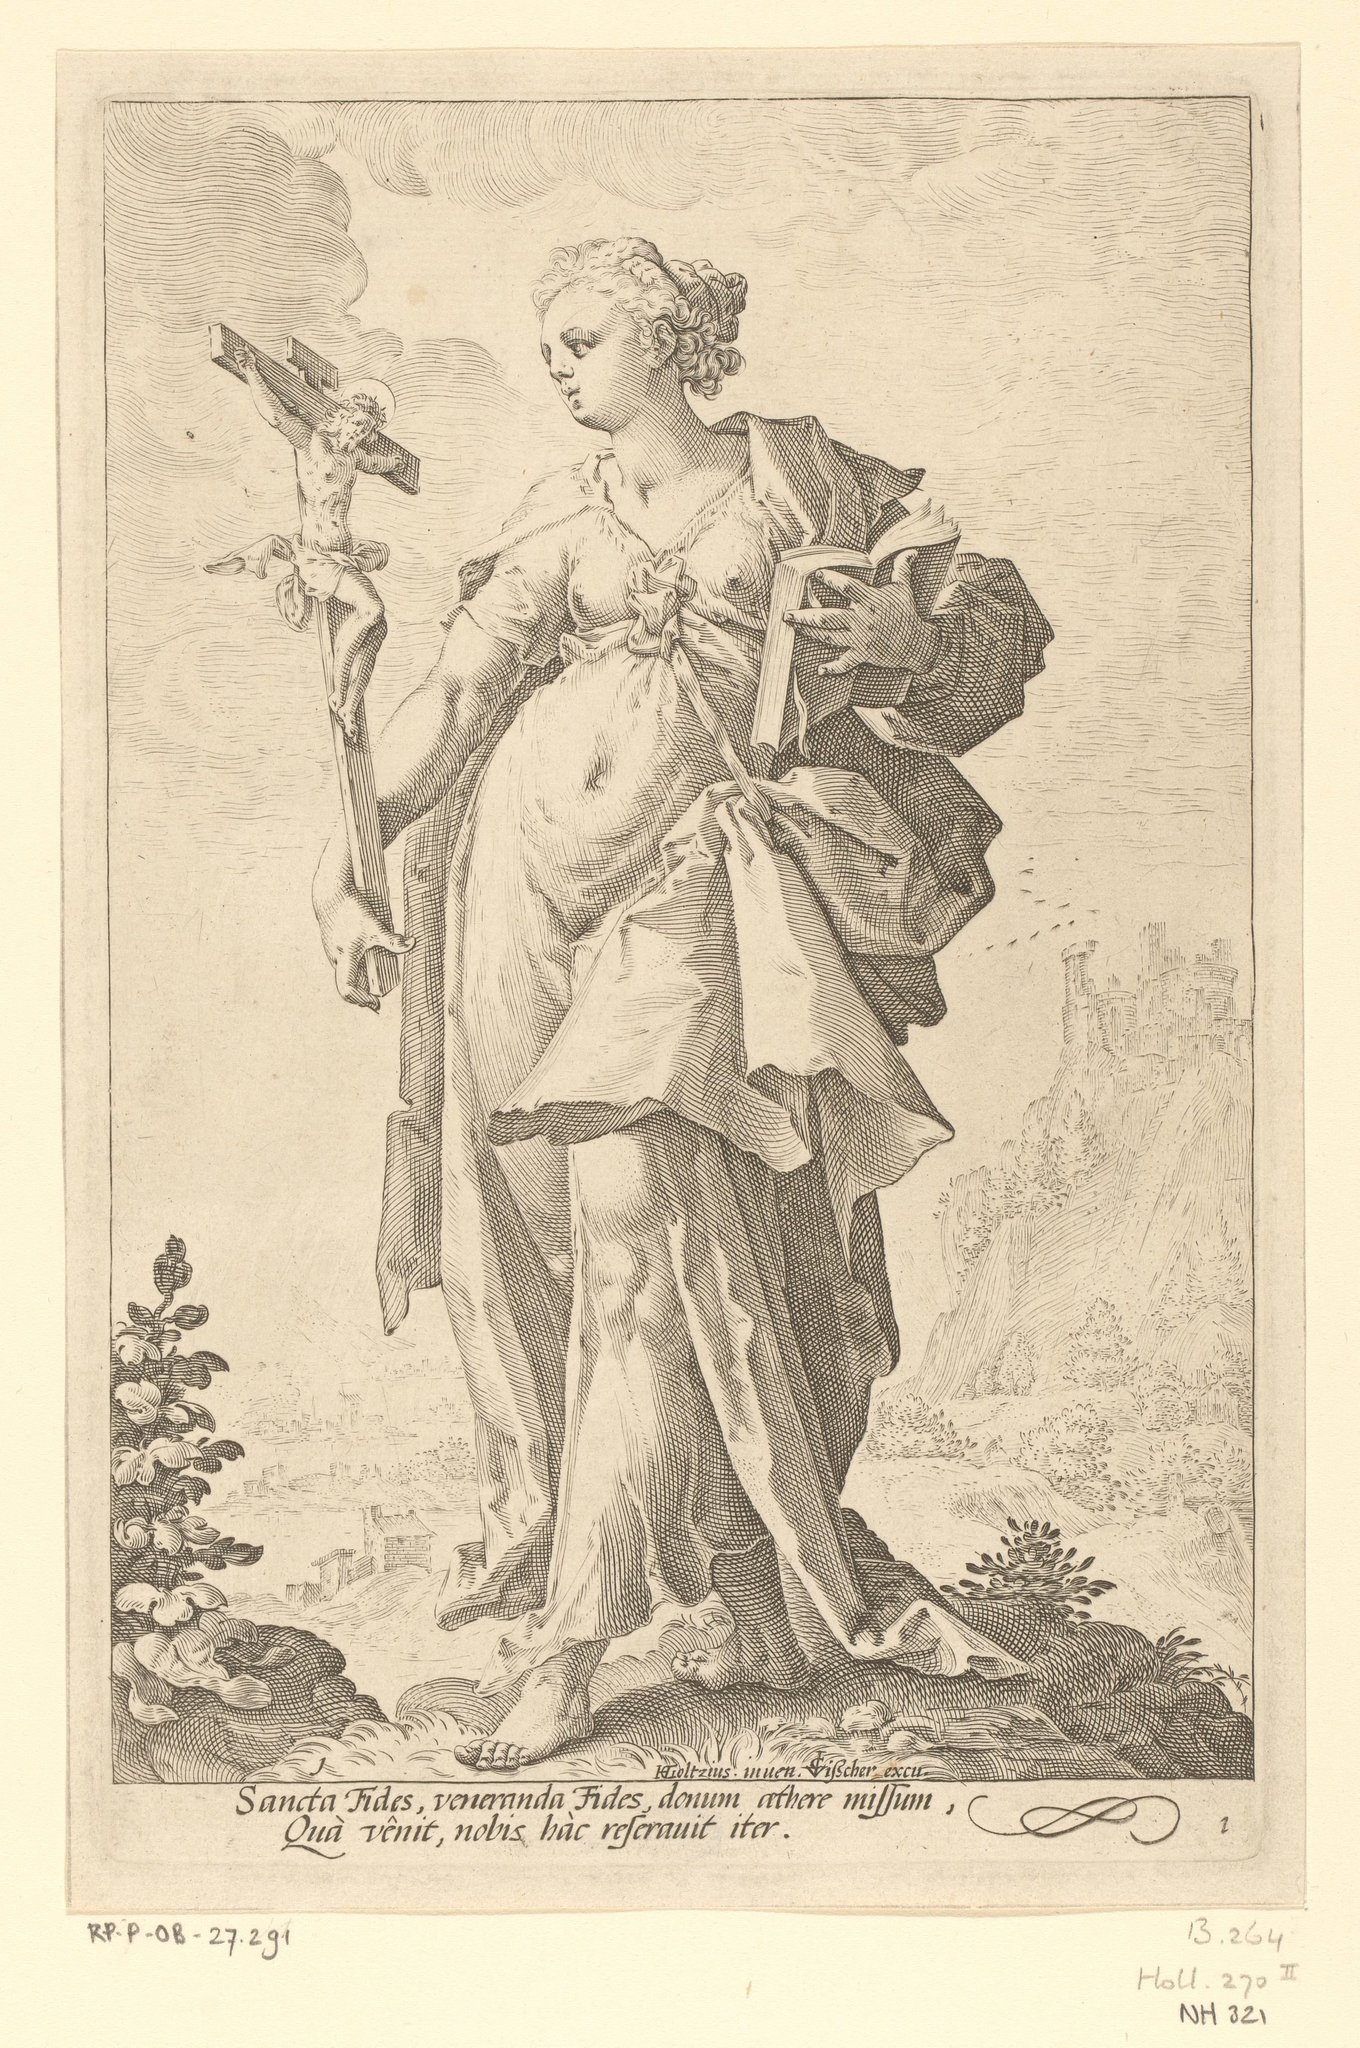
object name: print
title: De deugden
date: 1585-1589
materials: paper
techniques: engraving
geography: amsterdam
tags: faith, 'fides'; 'fede', 'fede catholica', 'fede christiana', 'fede christiana catholica' (ripa) ~ one of the three theological virtues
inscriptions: collector's mark: Lugt 2228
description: Het gepersonifieerde Geloof; een vrouwenfiguur met een crucifix en een bijbel.